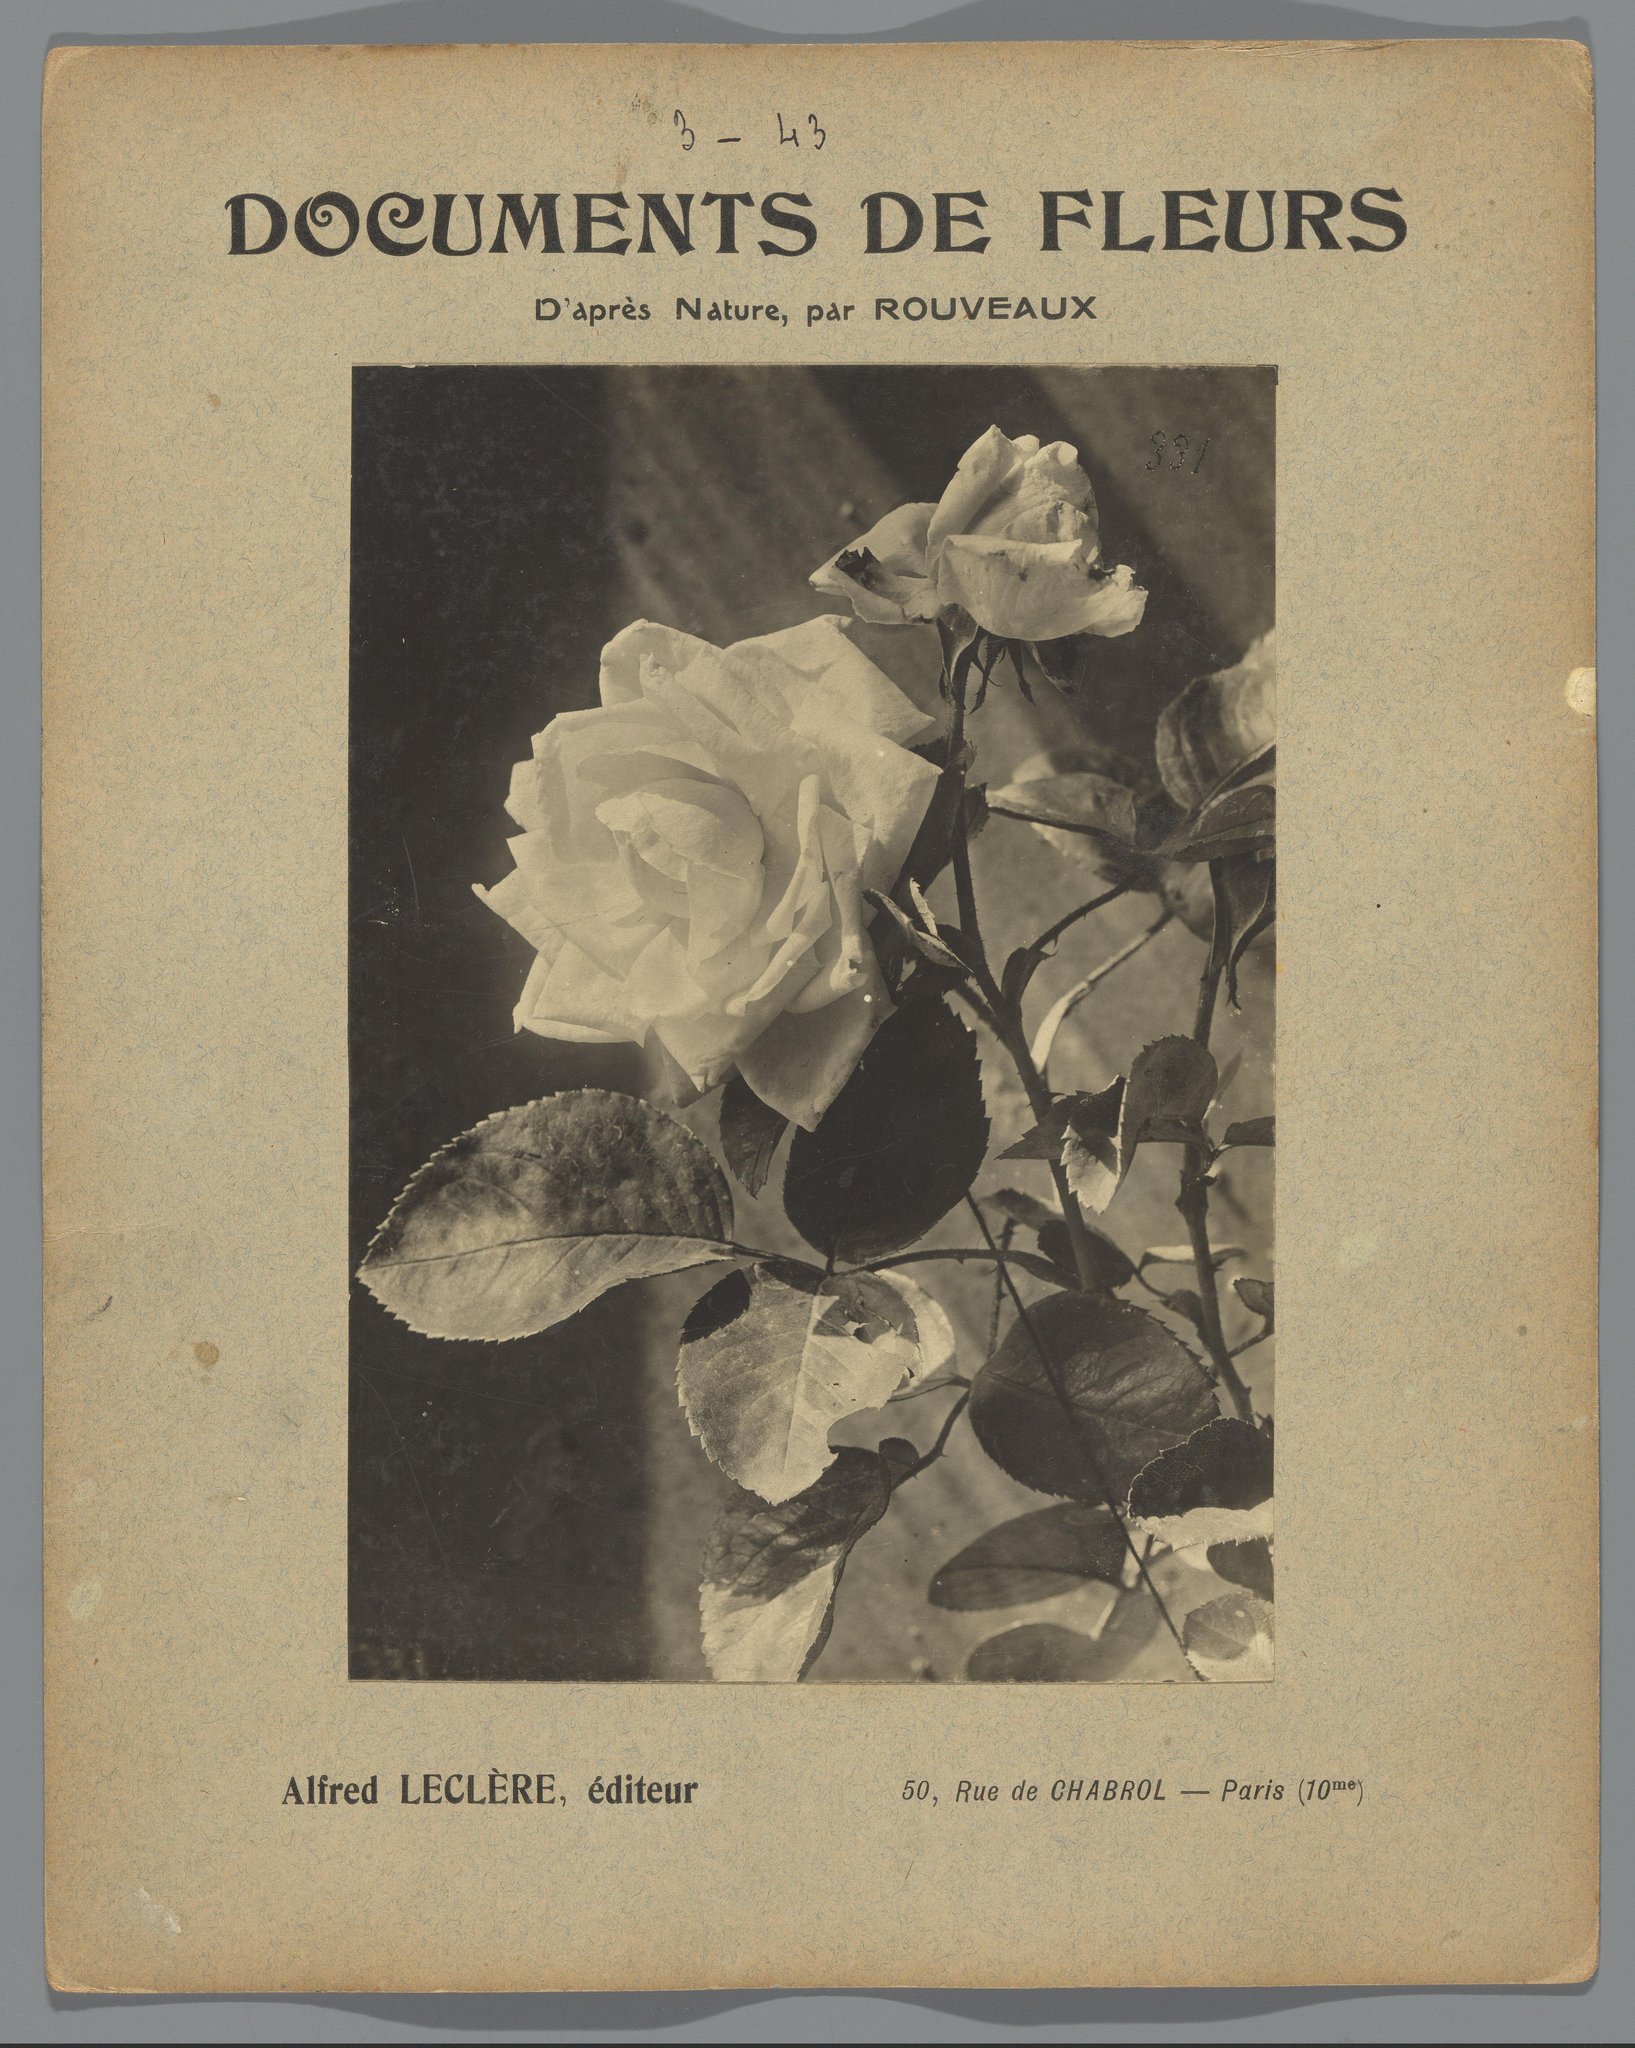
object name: photograph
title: Bloemstudie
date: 1895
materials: photographic support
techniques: gelatin silver print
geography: france